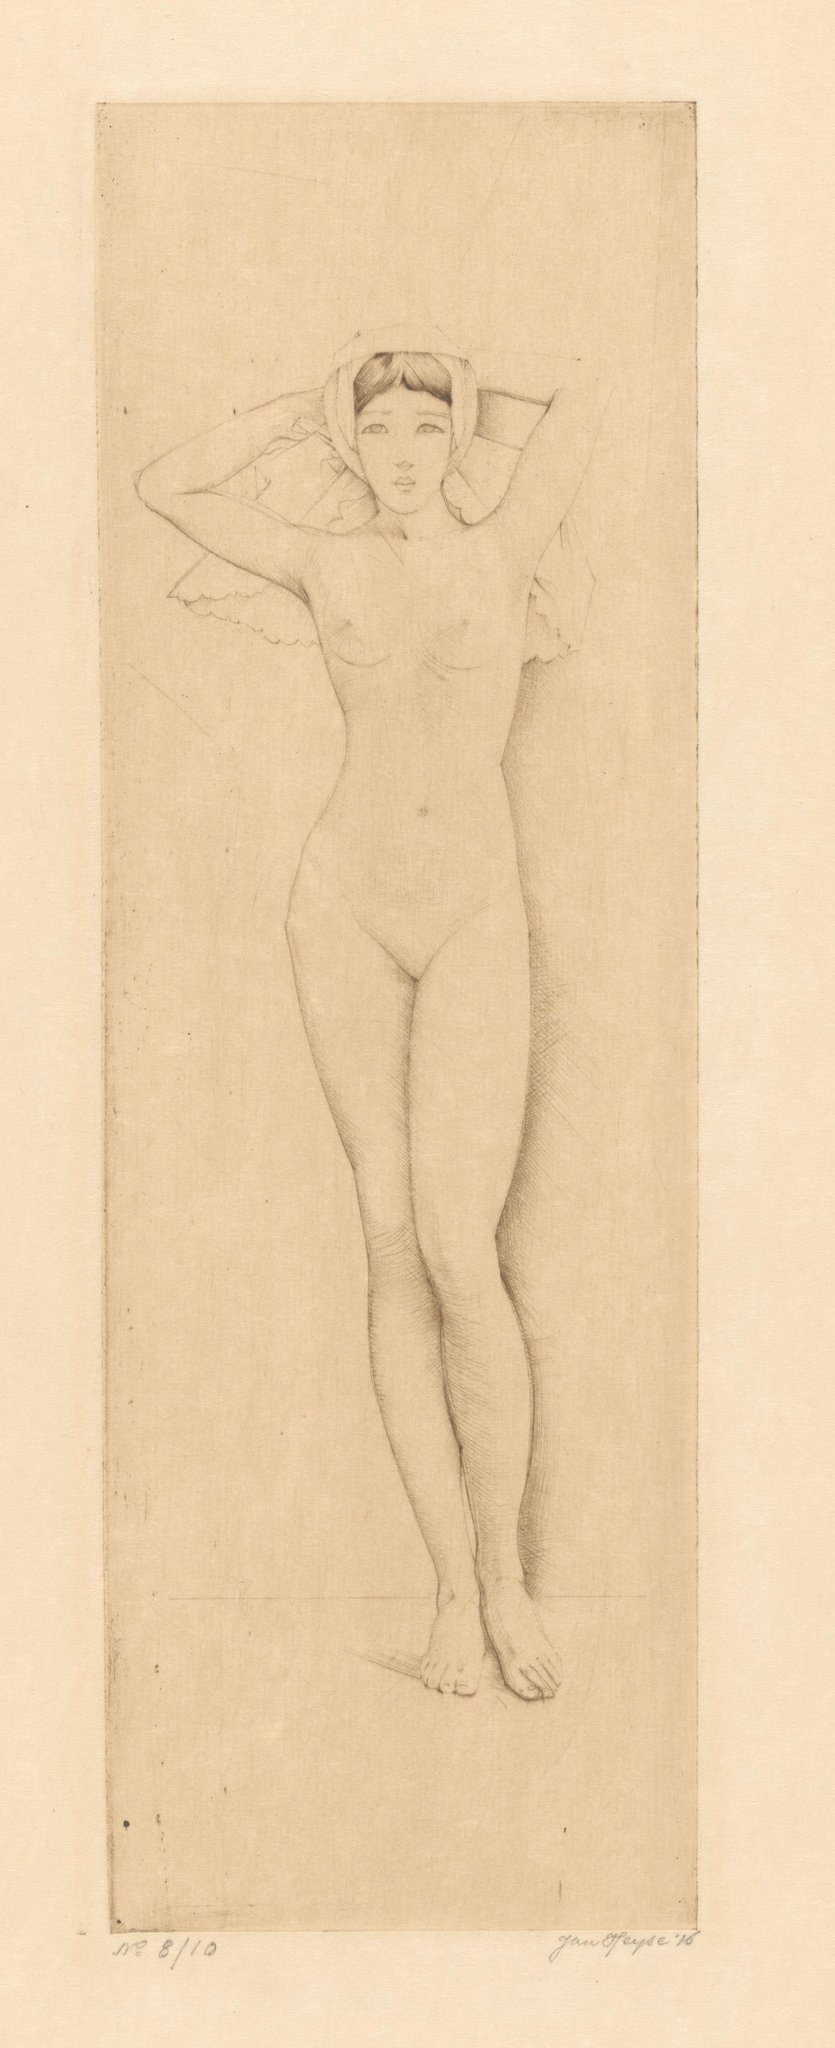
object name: print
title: Vrouwelijk naakt met Zeeuwse kap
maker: jan heyse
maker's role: painter, print maker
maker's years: 1882-1954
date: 1916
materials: paper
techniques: drypoint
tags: hand behind the head - aa - both arms or hands, woman (showing herself) undressed, quasi-nude, folk costume, regional costume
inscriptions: collector's mark: Lugt 2228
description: Jonge naakte vrouw staand met beide armen achter haar hoofd.